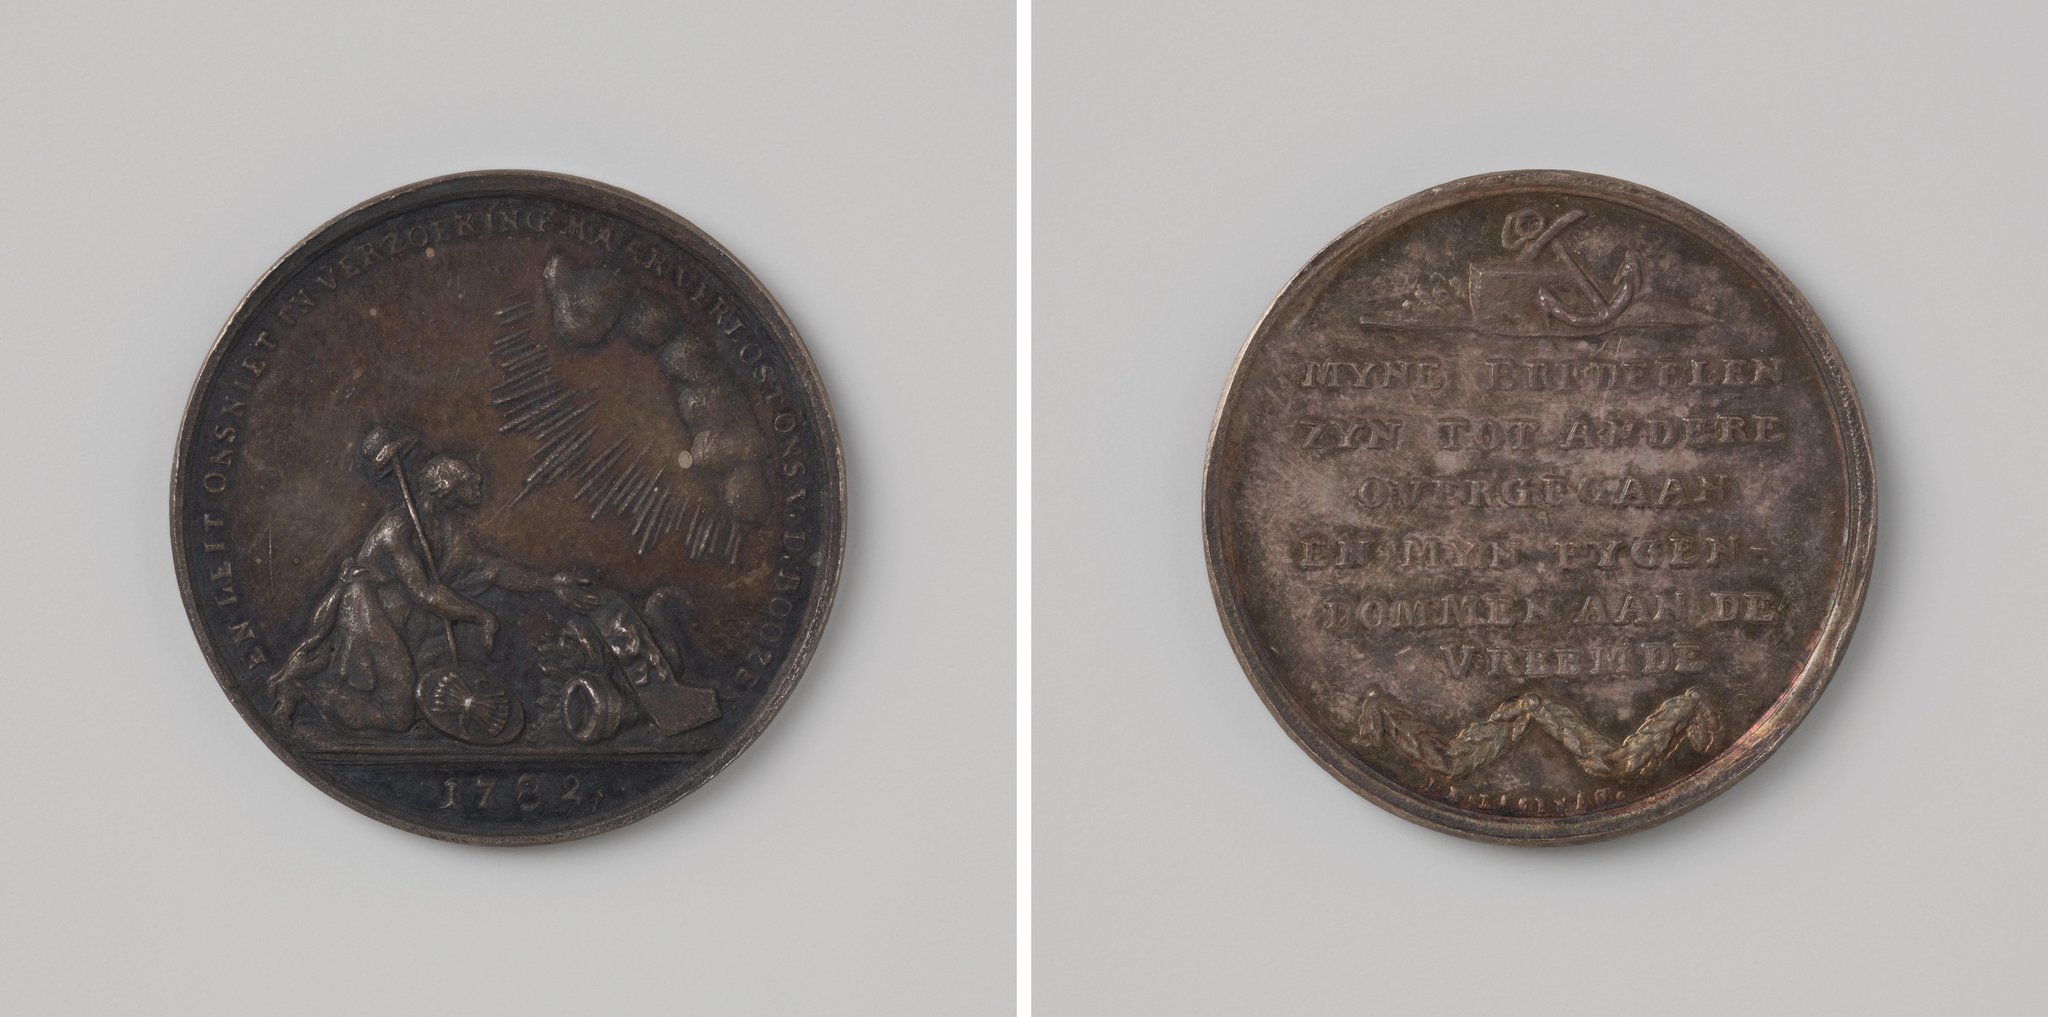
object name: new year medal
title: Aanvang van het jaar 1782 en de oorlog tegen Engeland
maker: johannes michiel lageman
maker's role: silversmith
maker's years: 1735-1809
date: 1782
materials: silver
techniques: striking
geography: amsterdam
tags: england, fourth anglo-dutch war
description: Zilveren penning. Voorzijde: beschenen door hemellicht knielt man met vrijheidshoed op lans en wapenschild aan zijn voeten bij lege hoorn van overvloed, waategen scheepsroer rust binnen omschrift; afsnede: jaartal. Keerzijde: opschrift boven een anker, dat tegen steen rust en guirlande